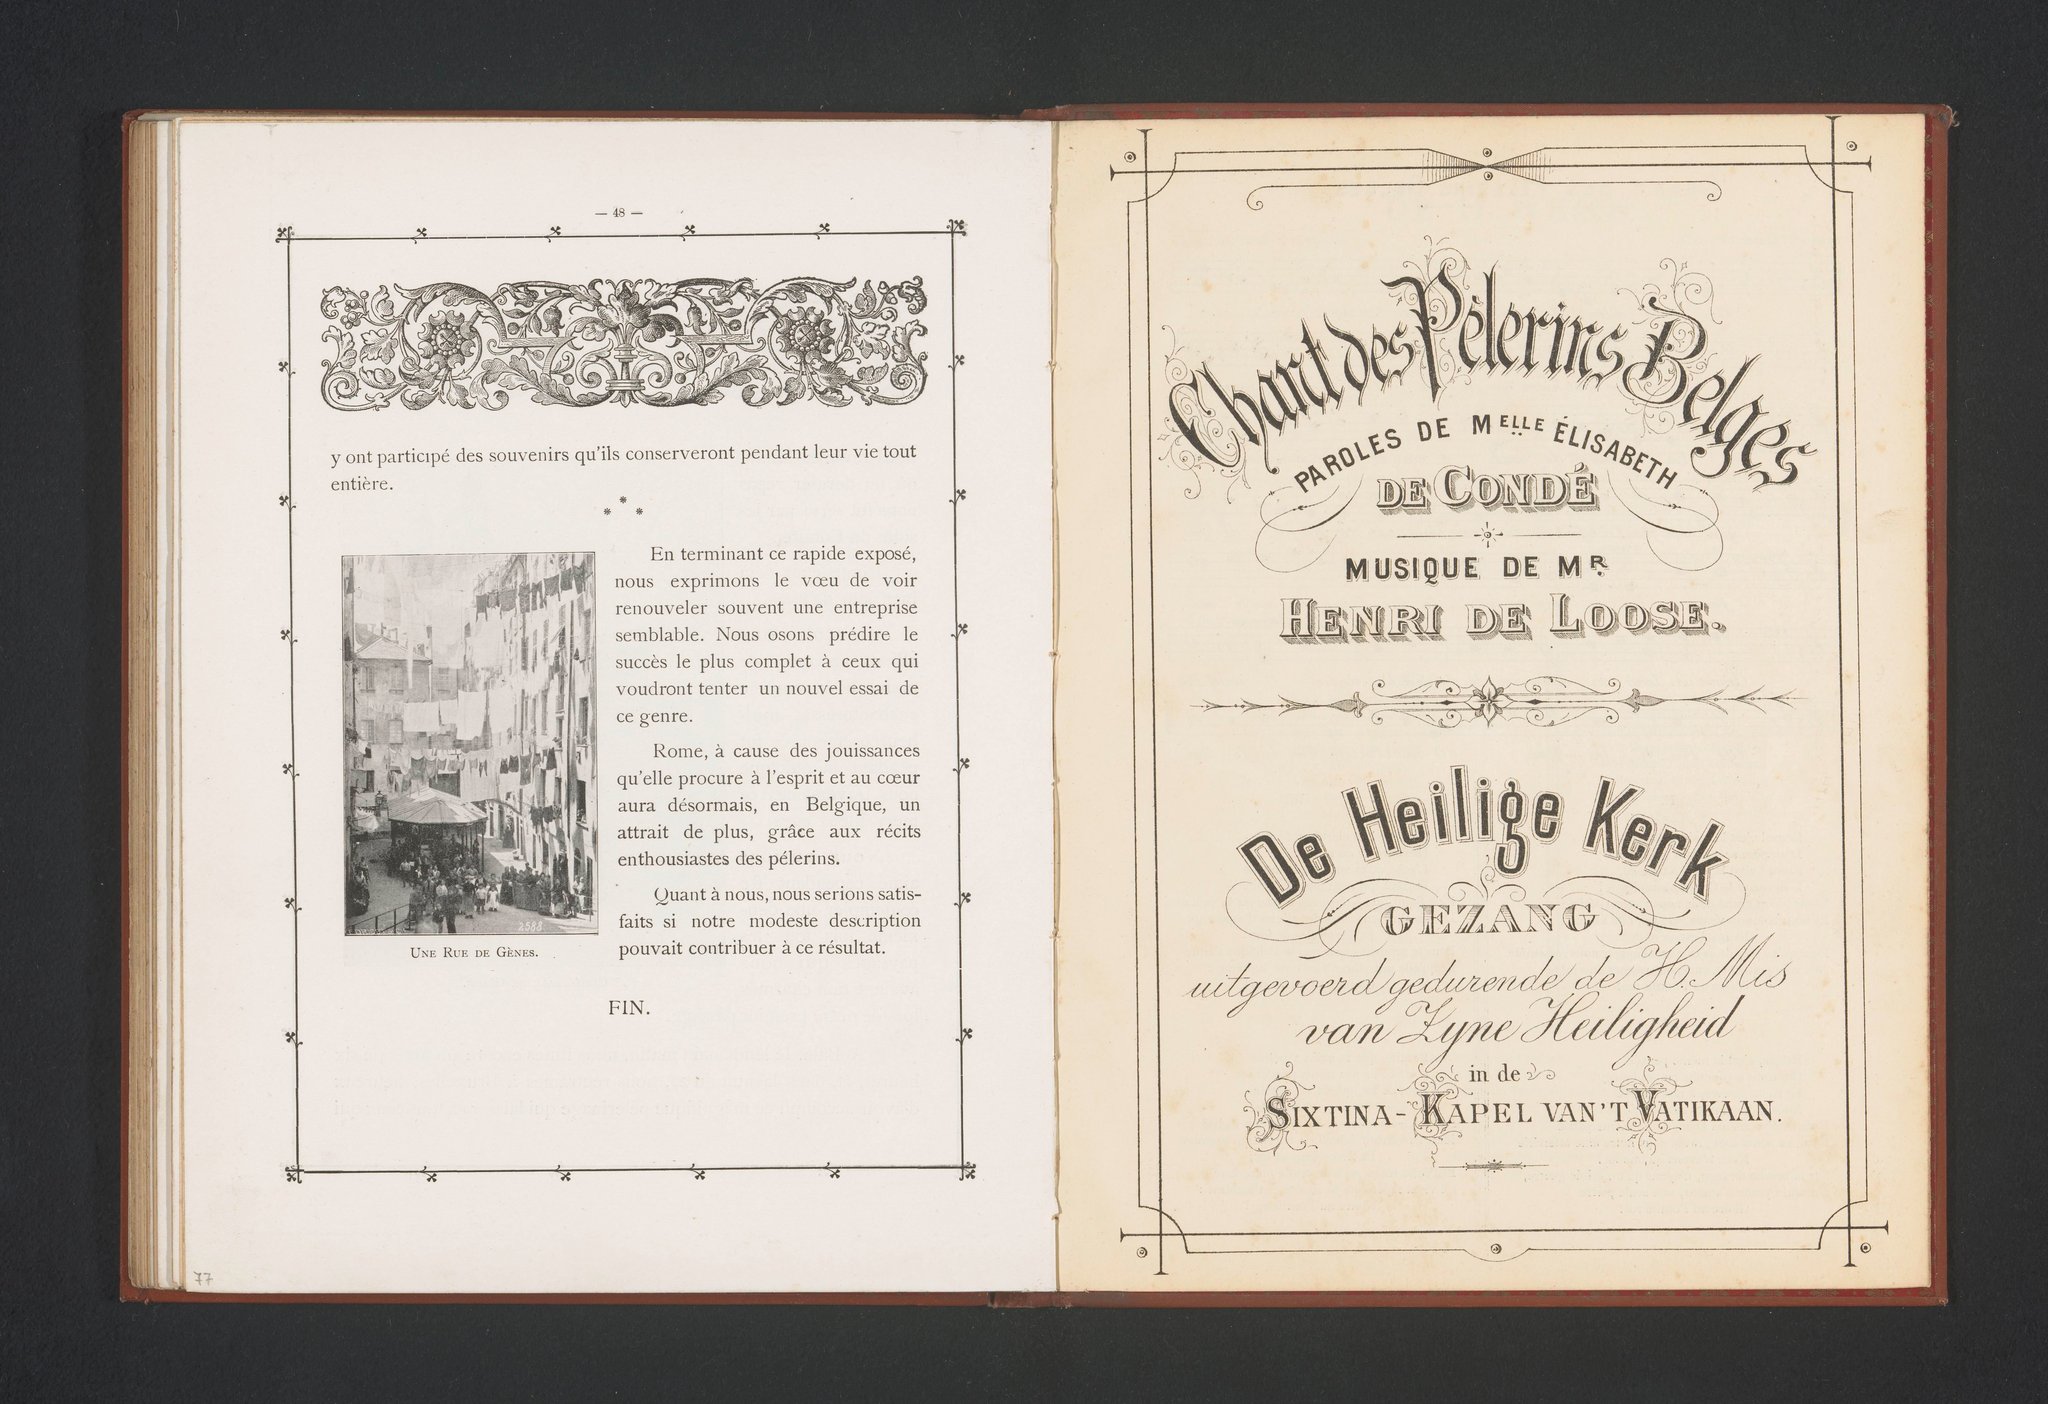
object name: photomechanical print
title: Gezicht op de straat Truogoli di S. Brigida in Genua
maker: alfredo noack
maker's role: fotograaf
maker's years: 1833-1895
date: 1875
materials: paper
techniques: autotype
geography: genoa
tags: street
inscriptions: number: ‘2588’